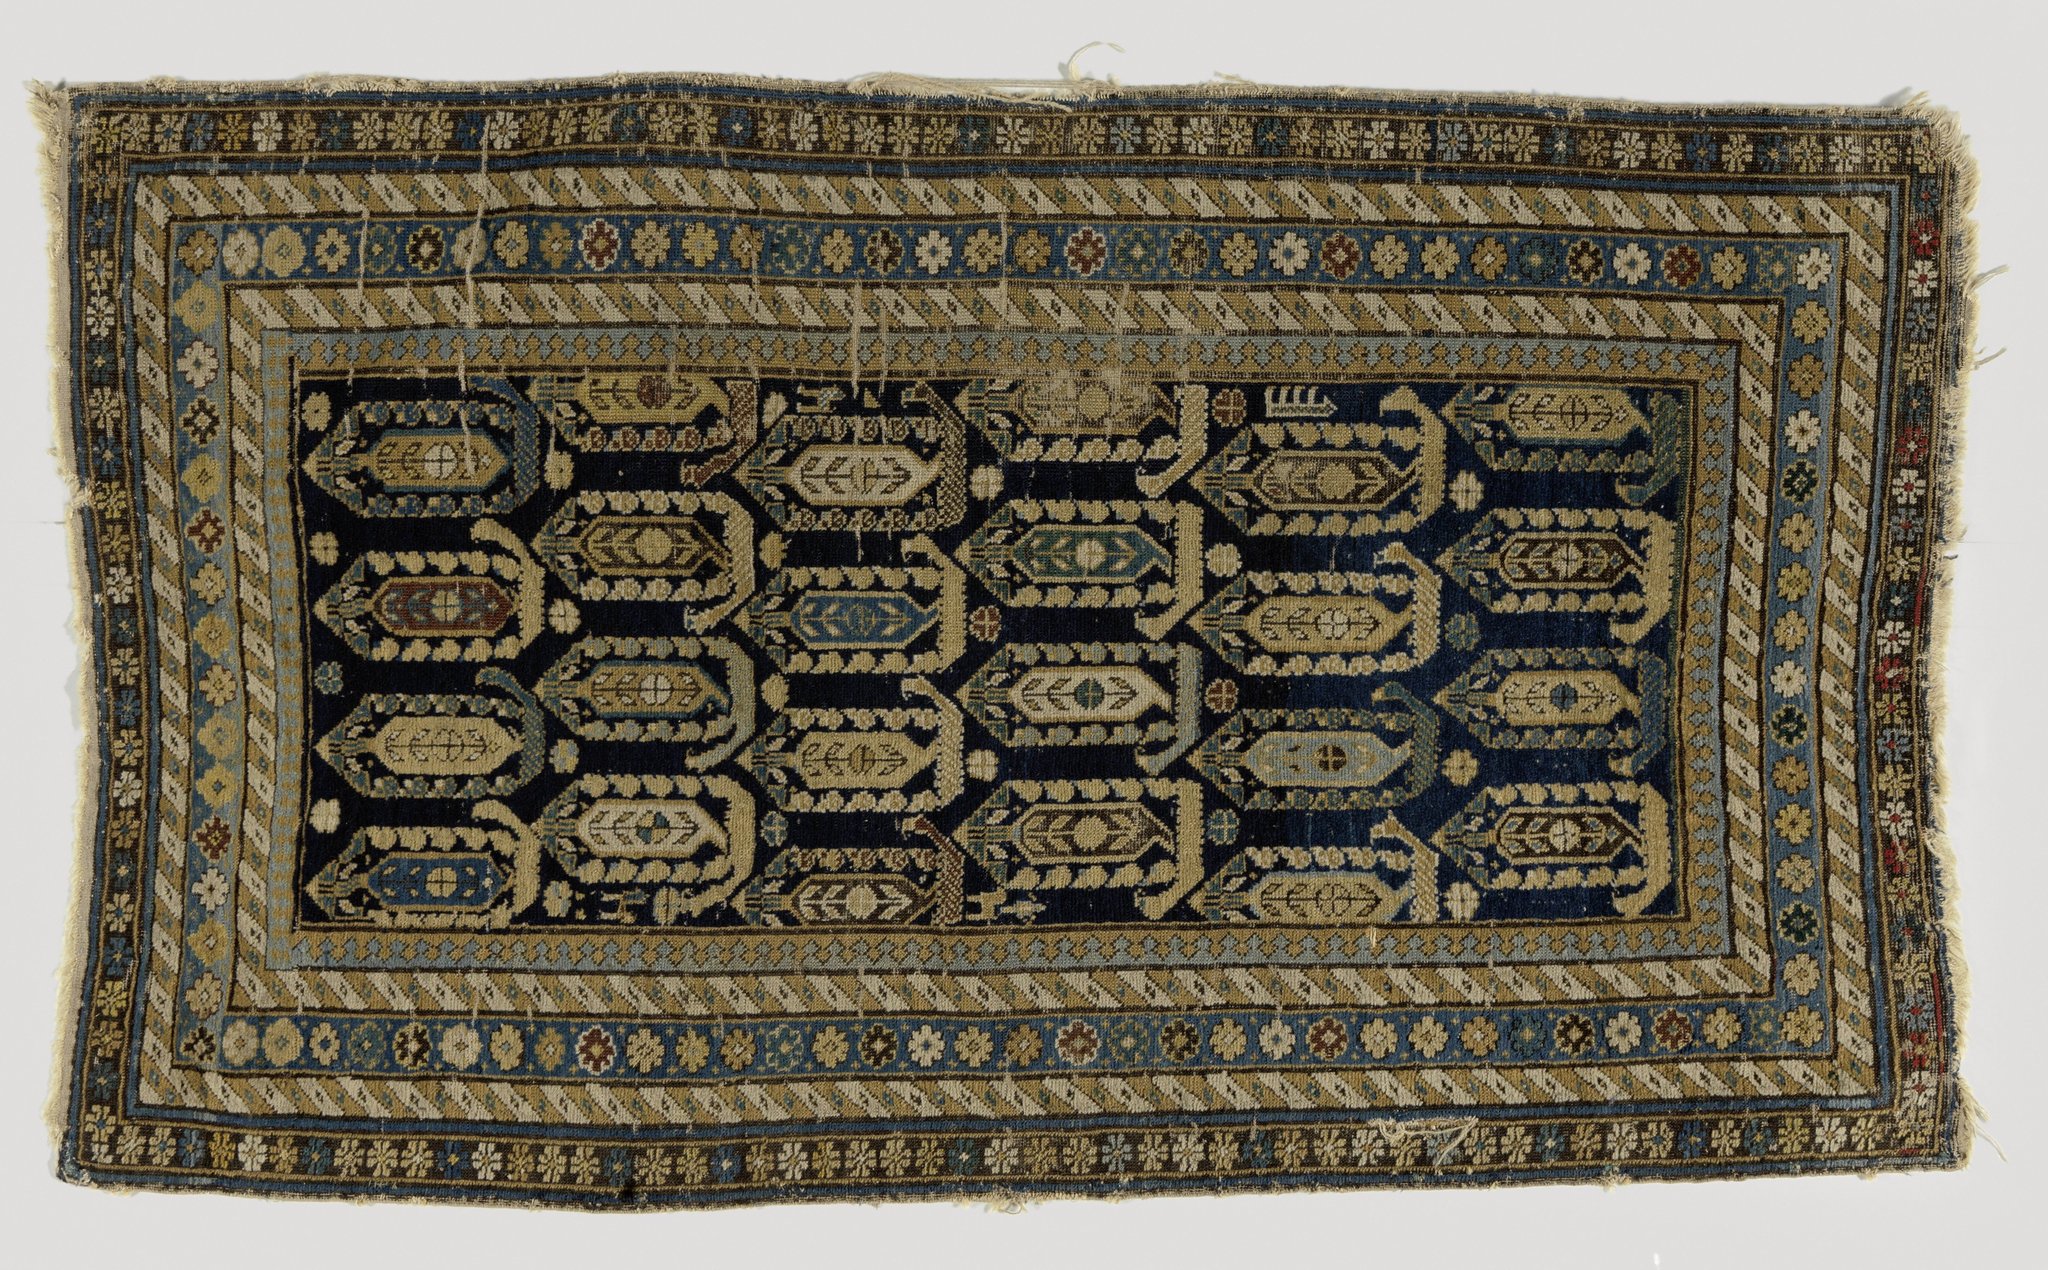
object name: oriental rug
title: Oosters tapijt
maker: Anonymous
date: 1800-1900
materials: wool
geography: caucasus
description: Oosters tapijt van geknoopte wol, waarvan het donkerblauwe middenveld versierd is met zes verspringende rijen botehs. Rondom vijf randen met effen tussenzomen.